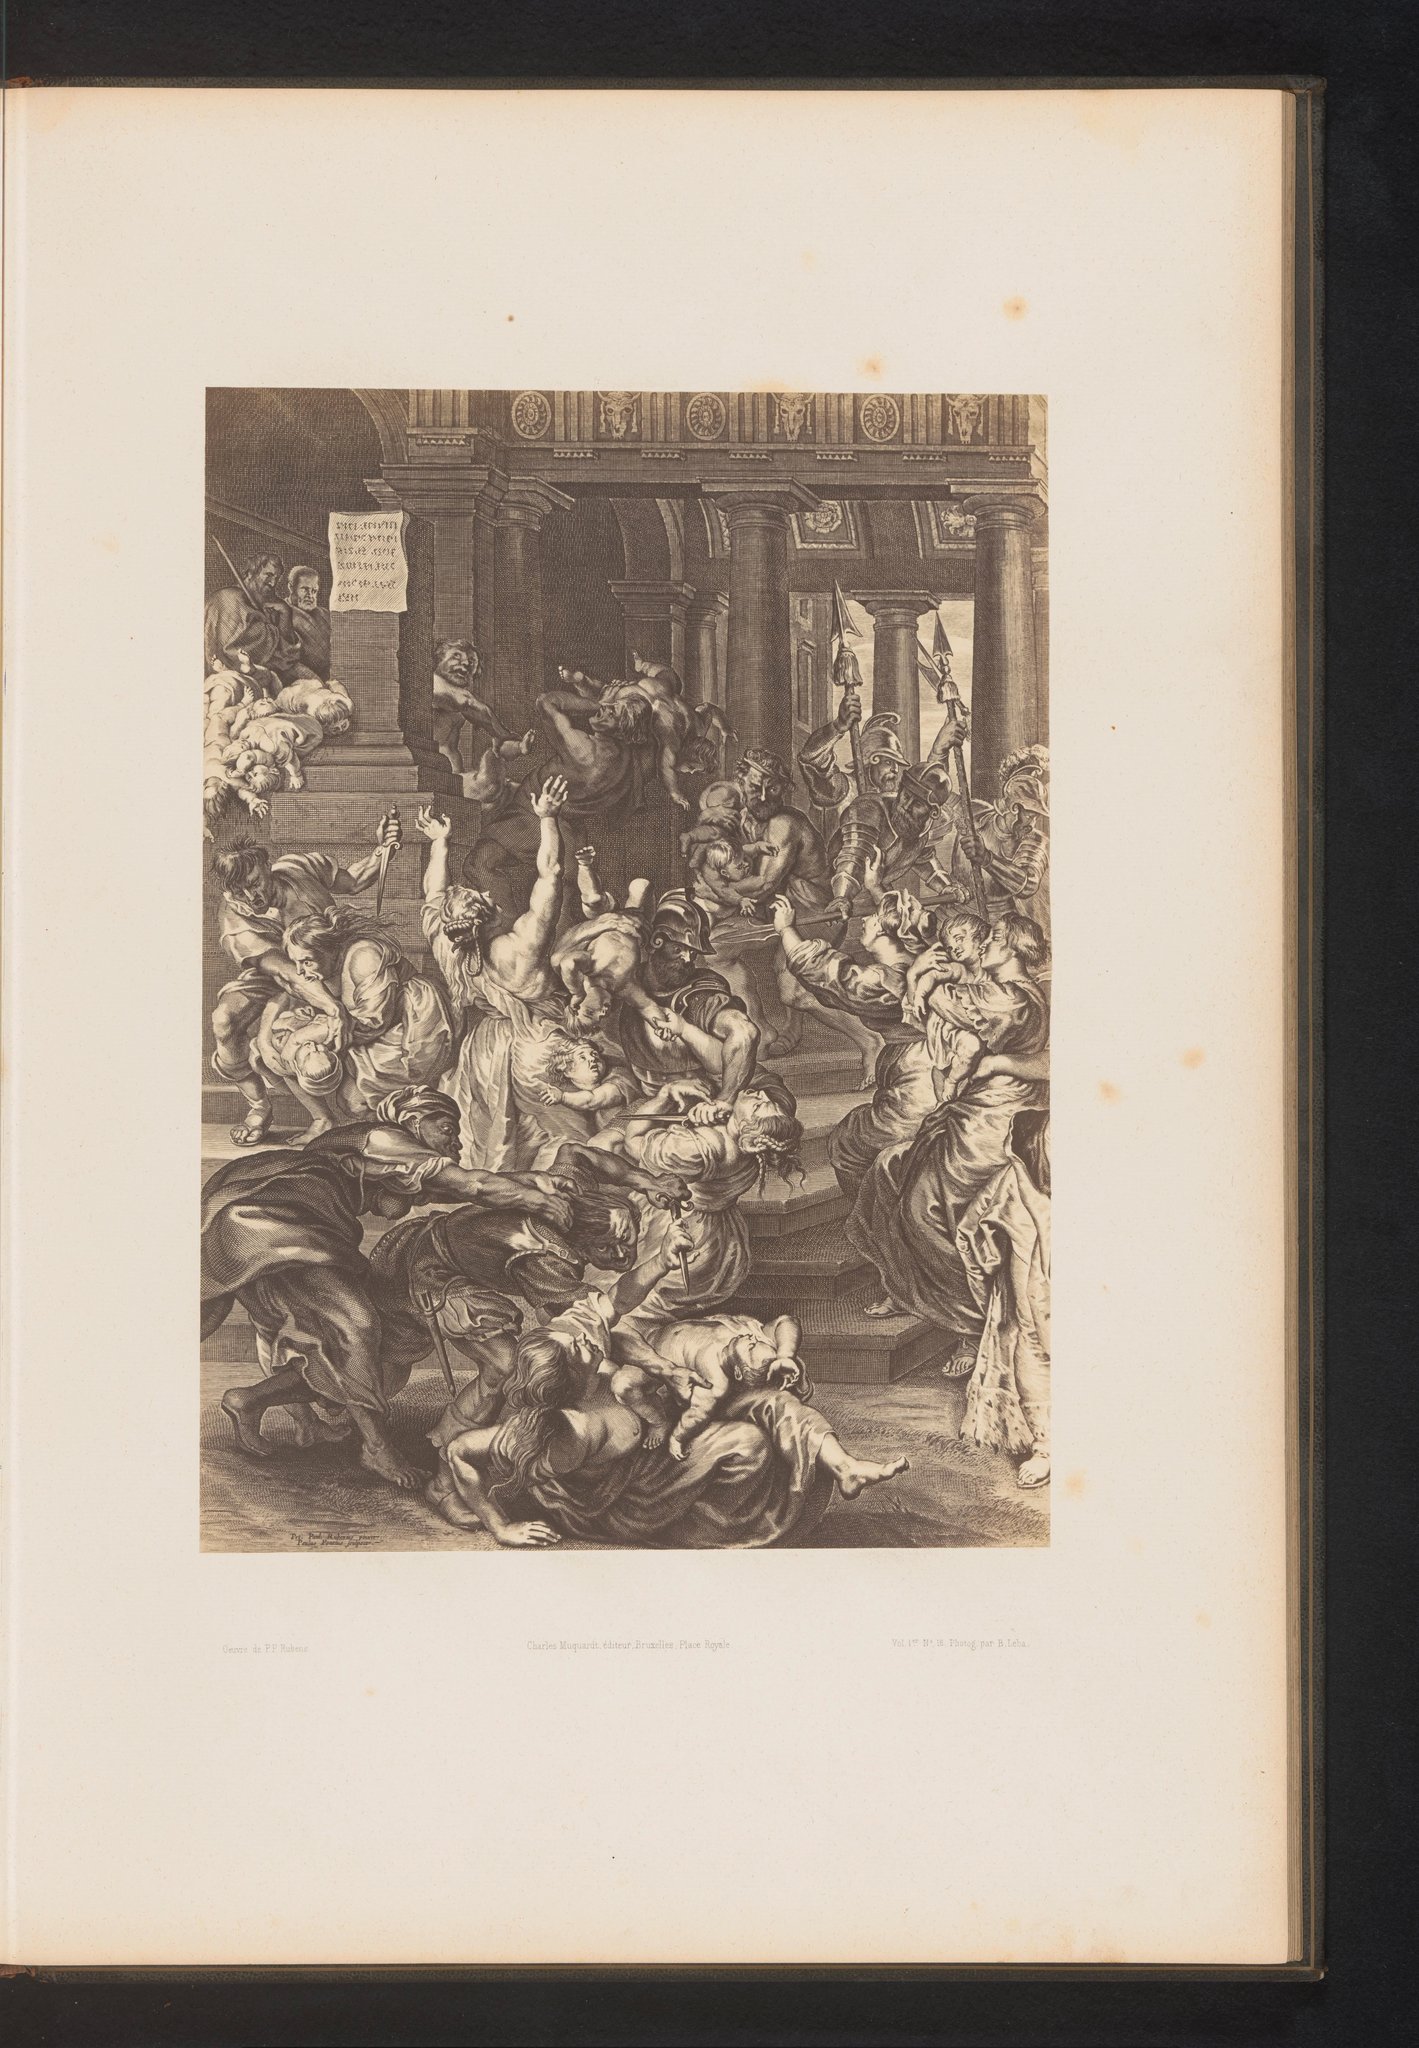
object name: photograph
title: Fotoreproductie van een gravure van De slachting der onschuldigen door Paulus Pontius, naar het schilderij door Peter Paul Rubens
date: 1853-1858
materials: photographic support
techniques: albumen print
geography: brussels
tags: the massacre of the innocents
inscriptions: number: ‘Vol. 1er. No 18.’